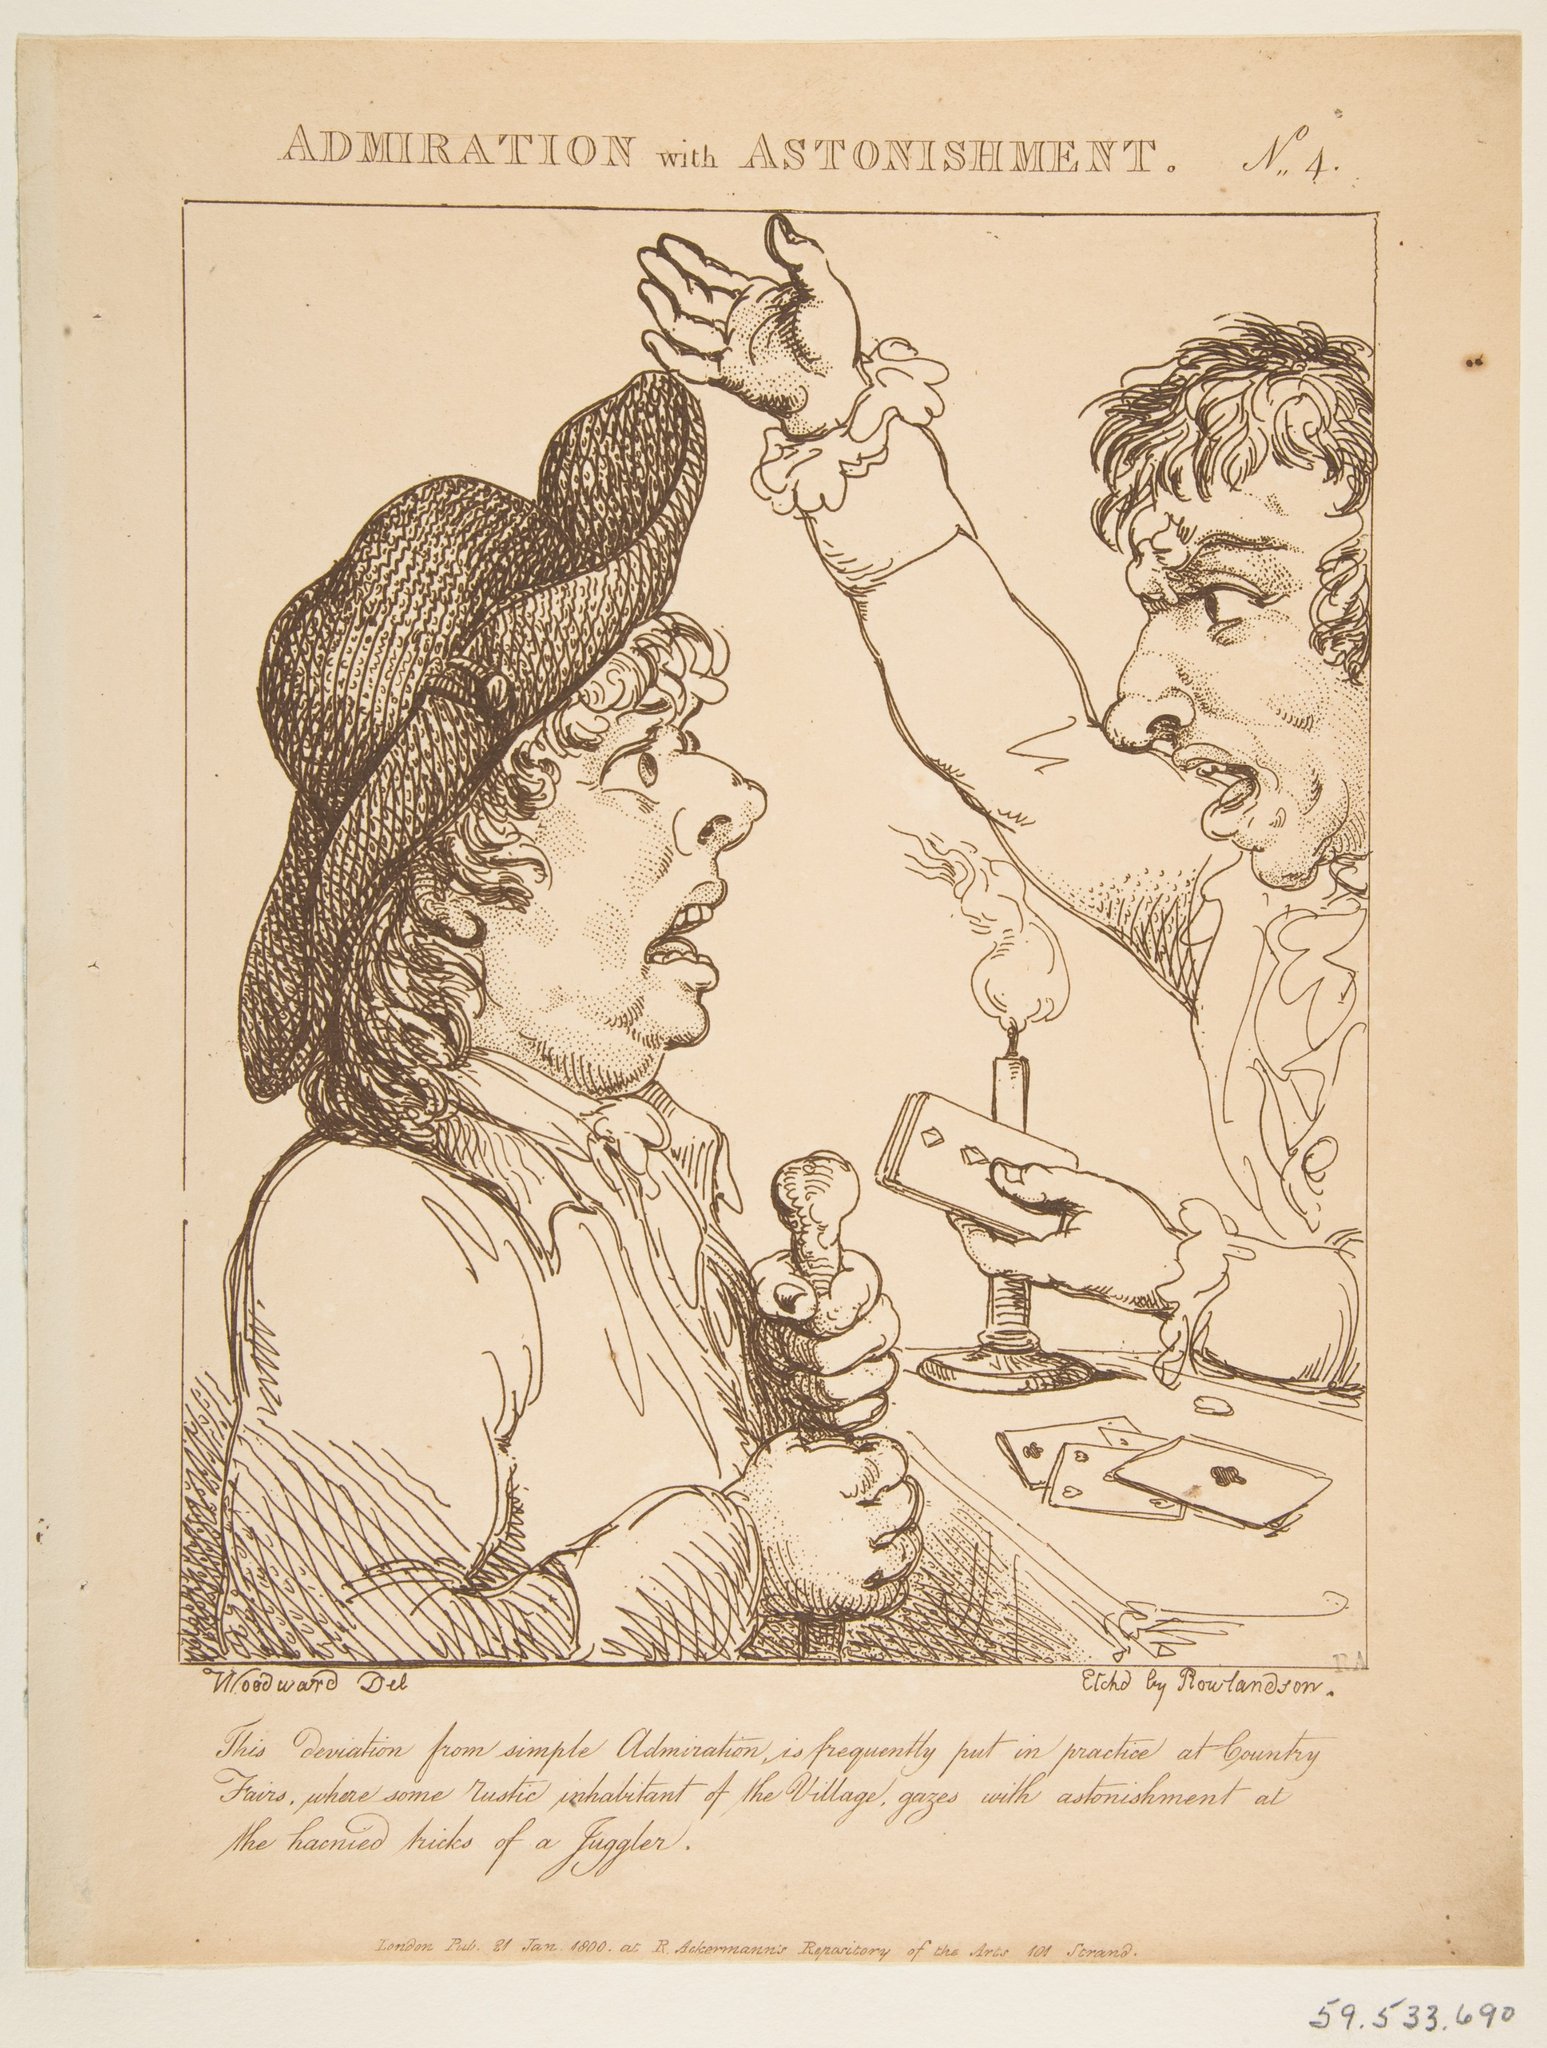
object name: print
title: Admiration with Astonishment (Le Brun Travested, or Caricatures of the Passions)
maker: thomas rowlandson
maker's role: artist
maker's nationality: british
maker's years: 1757-1827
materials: ink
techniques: etching, printing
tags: men,women,playing cards